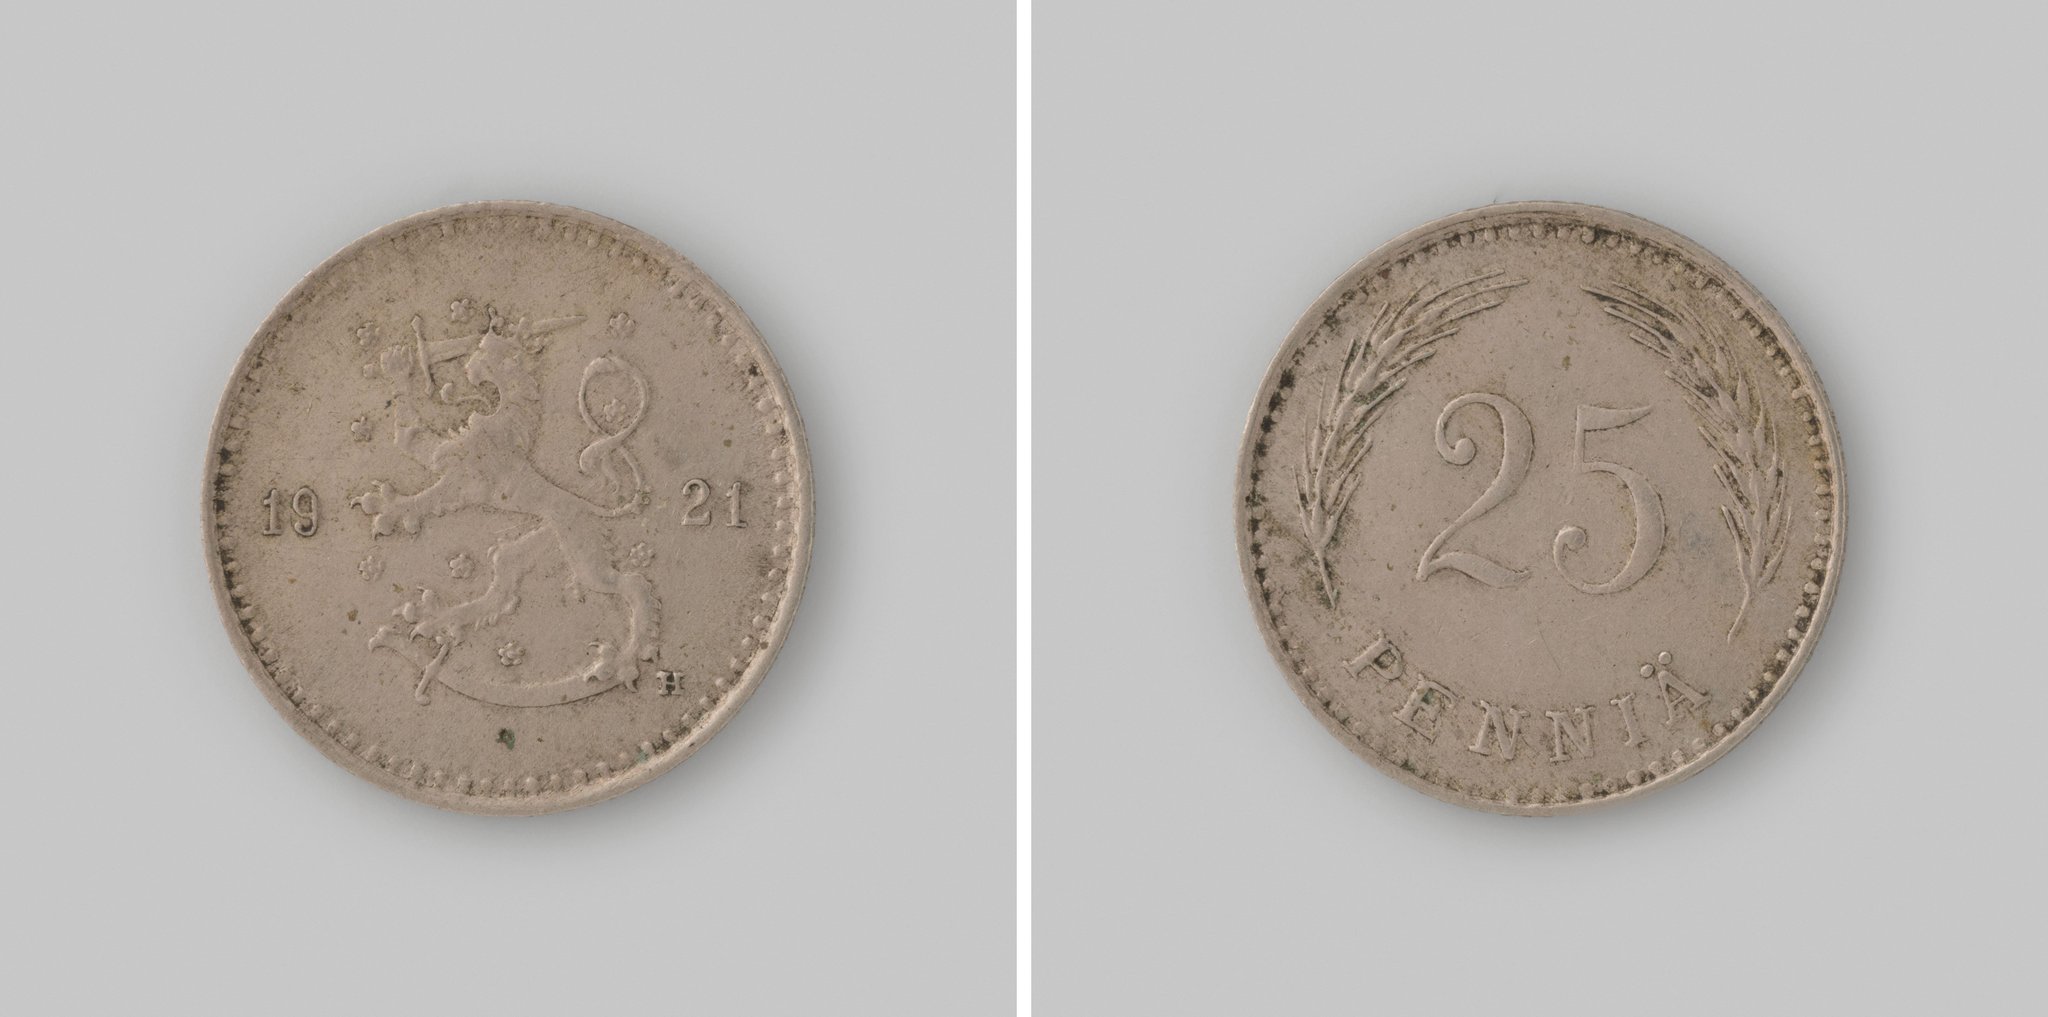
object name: coin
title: 25 penniä uit Finland, 1921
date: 1921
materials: nickel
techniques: striking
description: Koper-nikkelen munt. Voorzijde: tussen jaartal wapen van Finland. Keerzijde: tussen twee takken waarde-aanduiding in twee regels. Kartelrand.